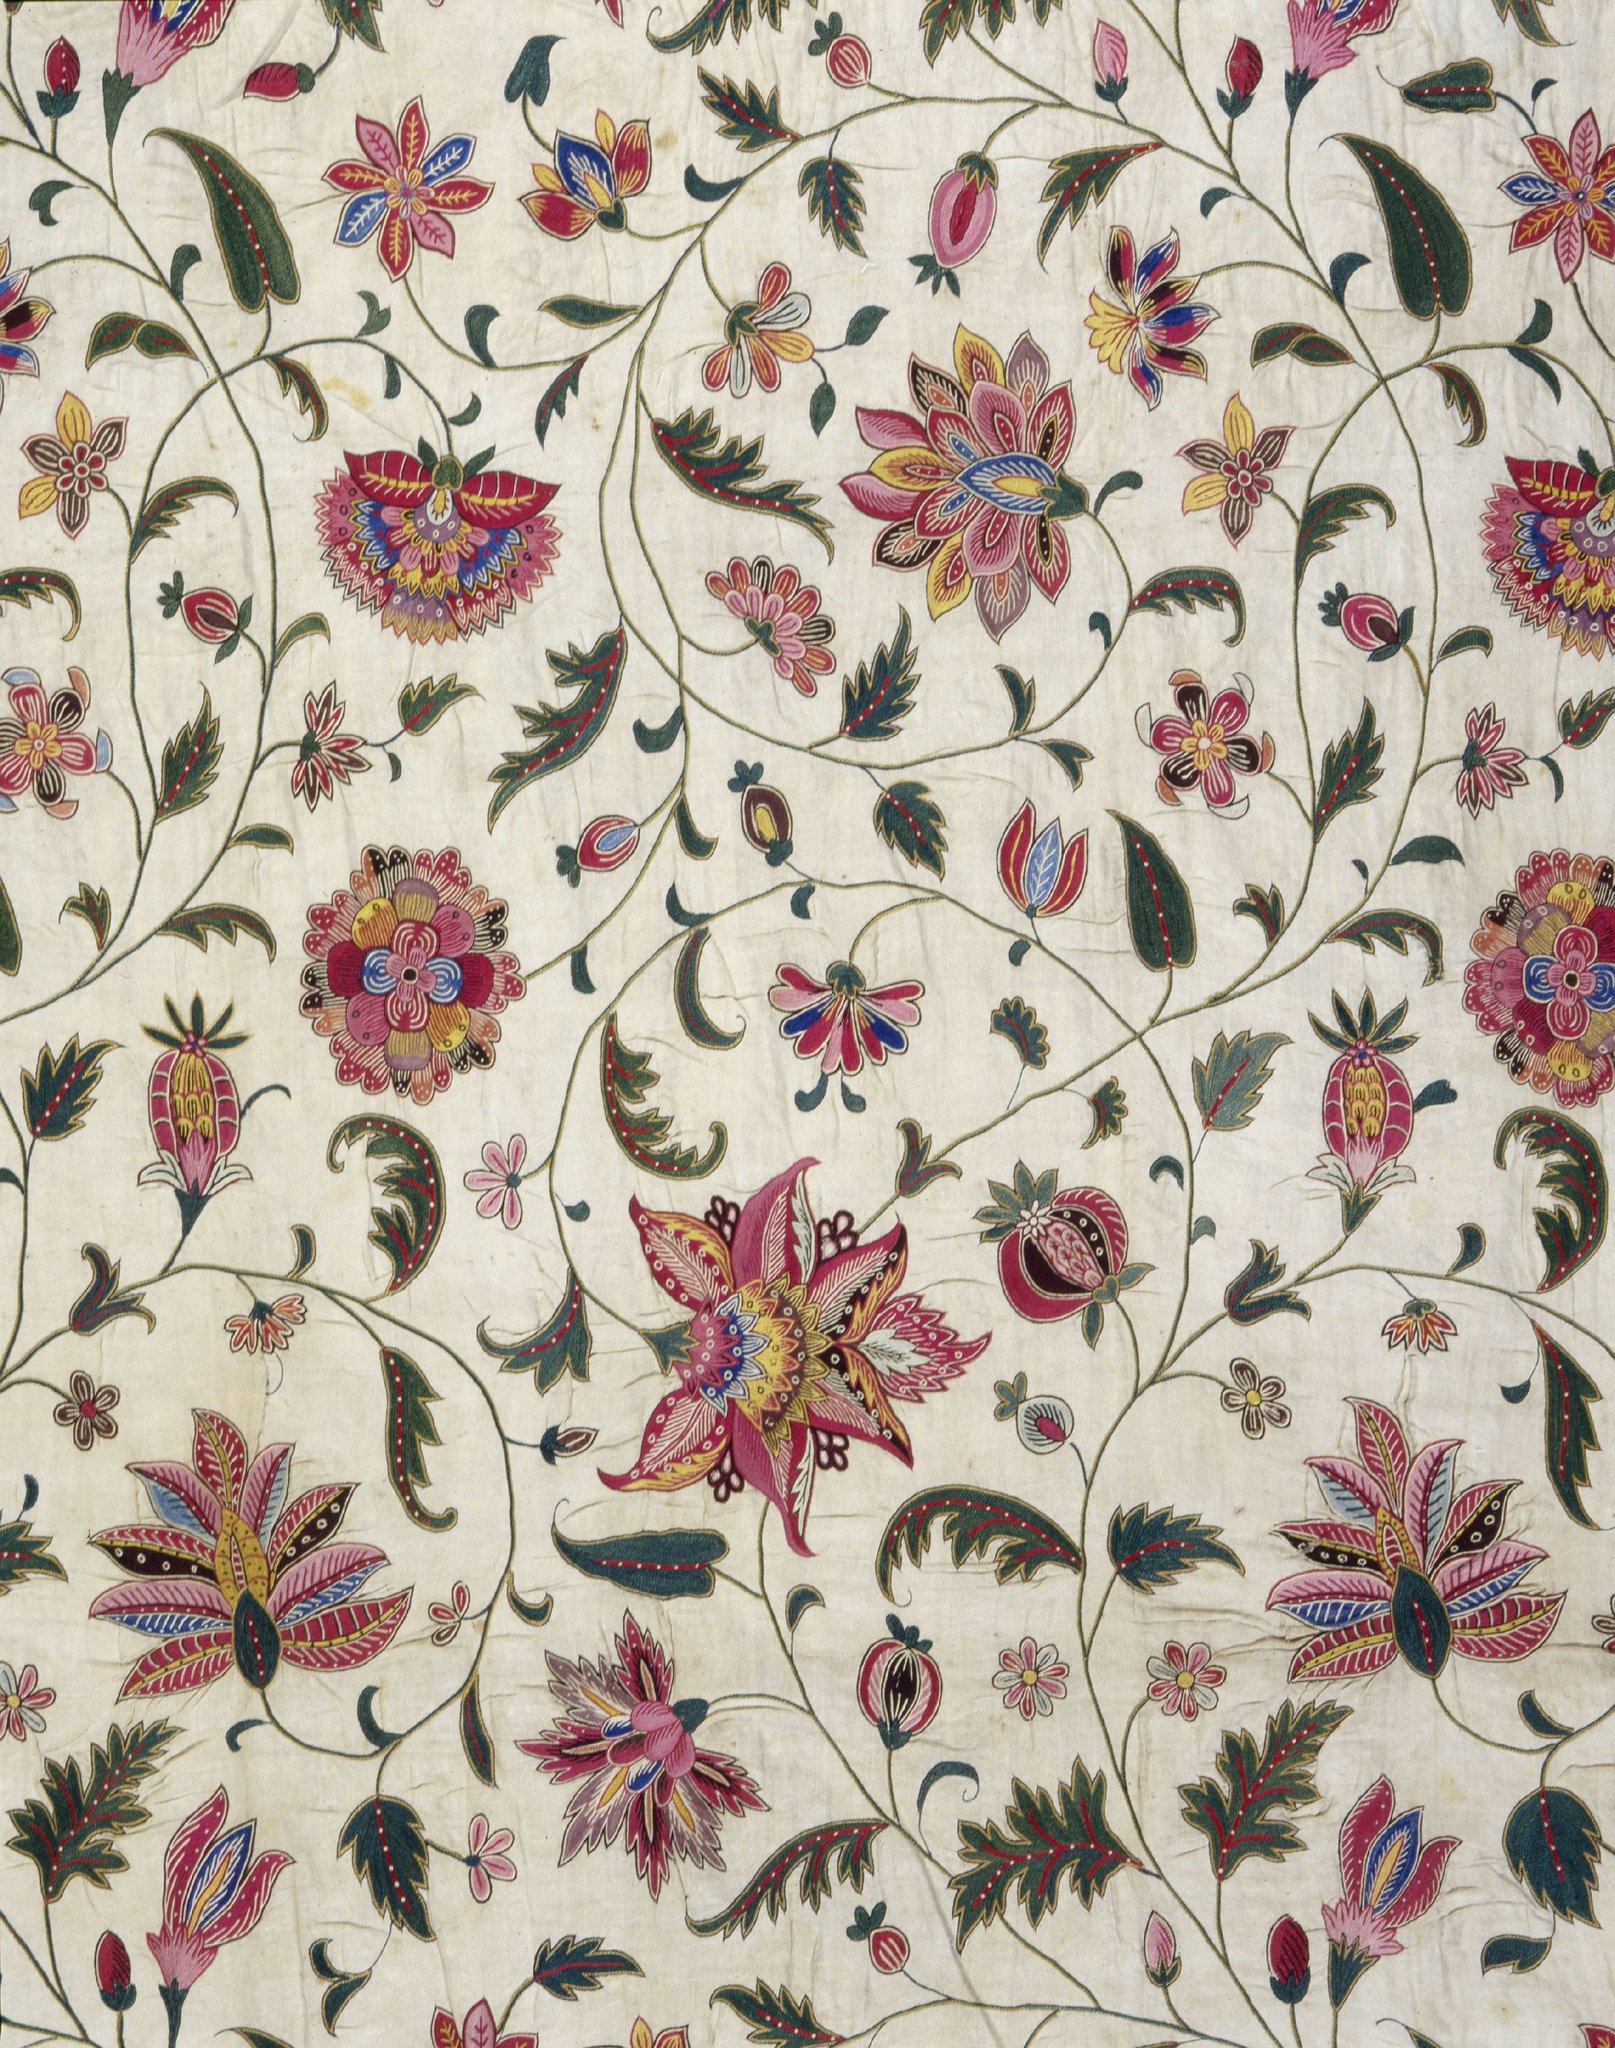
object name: bed covering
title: Fragment of an Embroidered Coverlet in Asian Fabric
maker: Anonymous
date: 1720-1740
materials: cotton, silk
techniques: embroidered, weave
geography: gujarat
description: Fragment van een veelkleurig getamboereerde Indiase sprei, versierd met voluten en bloemen.